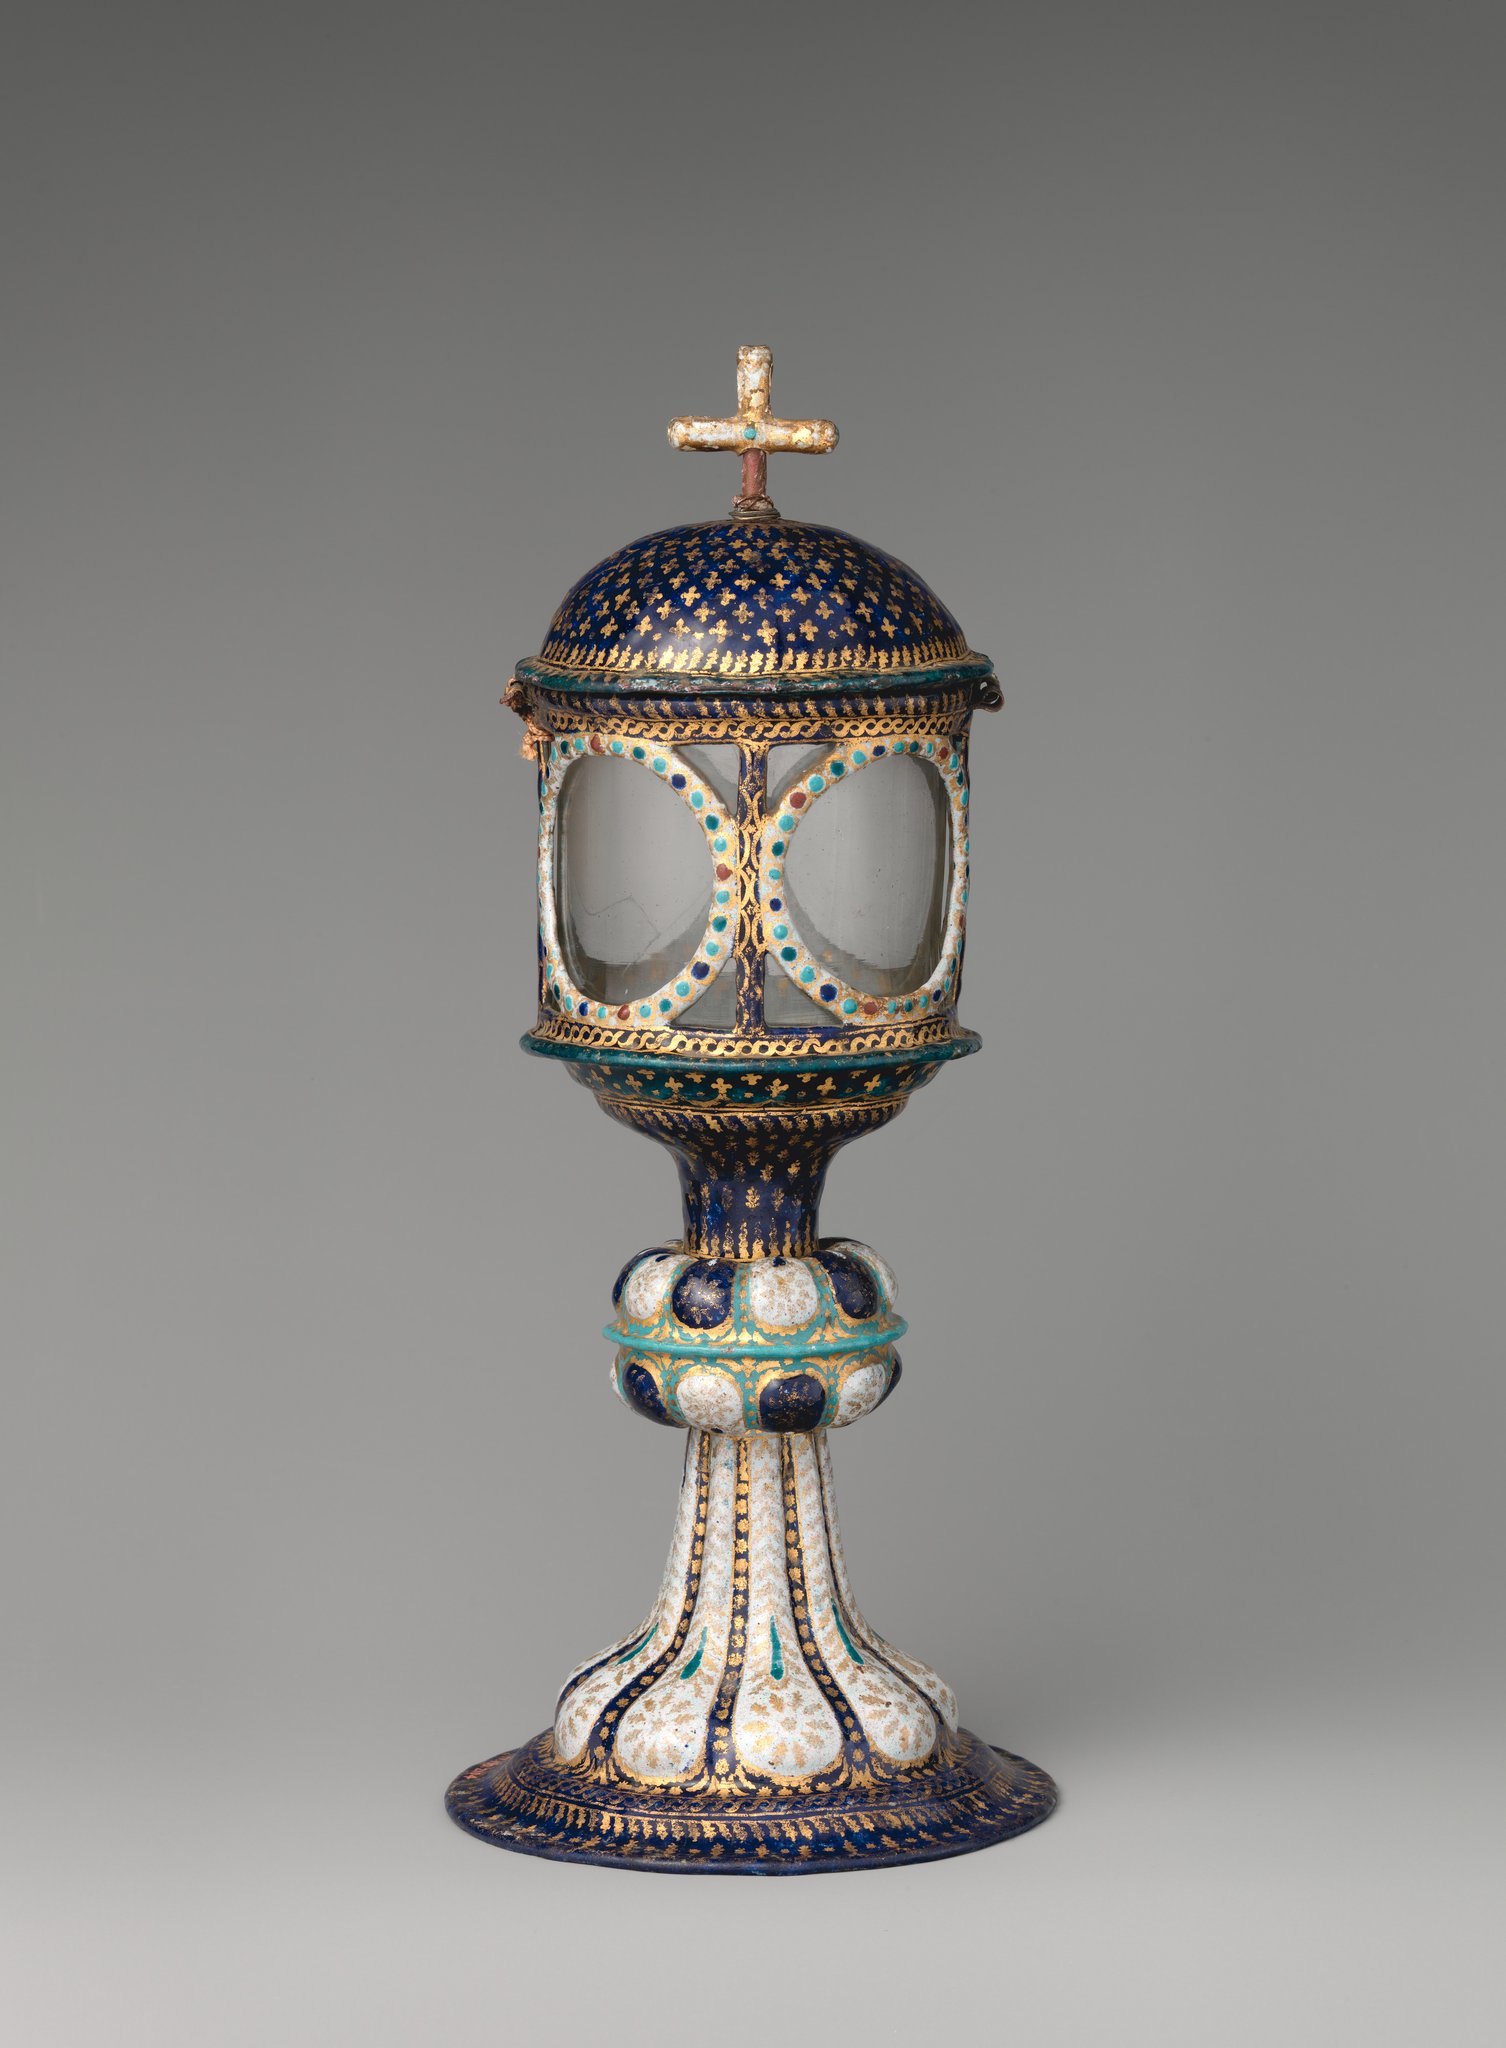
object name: reliquary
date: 1467-1533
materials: copper, enamel, gilt, glass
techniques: painting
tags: cross,reliquaries